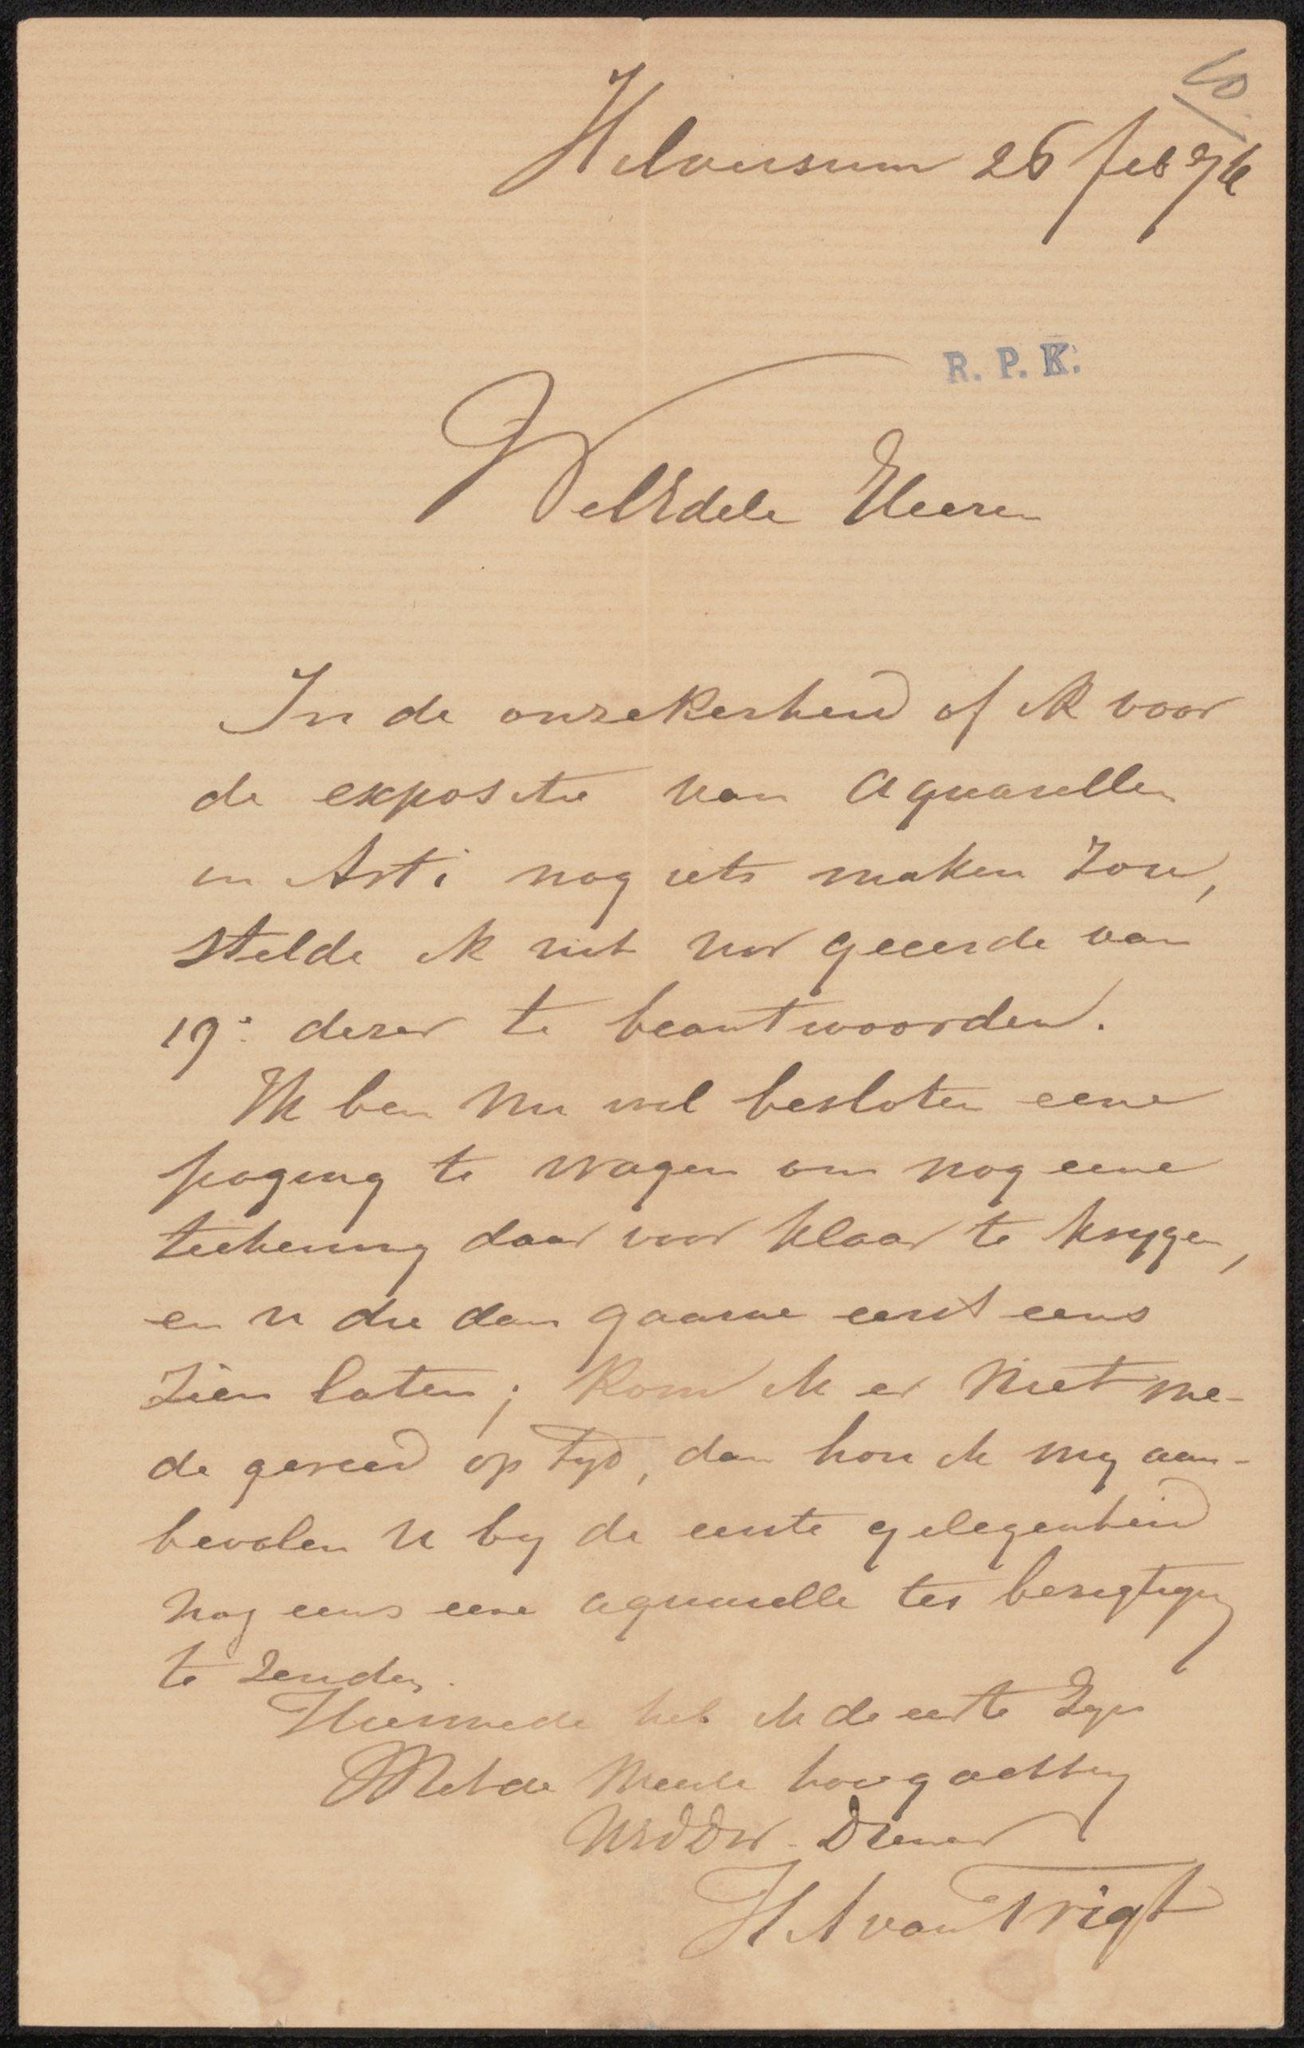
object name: letter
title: Brief aan Frans Buffa en Zonen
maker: hendrik albert van trigt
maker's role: draughtsman, painter, print maker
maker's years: 1829-1899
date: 1874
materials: ink, paper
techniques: pen, writing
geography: hilversum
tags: art trade, art shop, drawing, exhibition ~ art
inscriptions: collector's mark: Lugt 2233